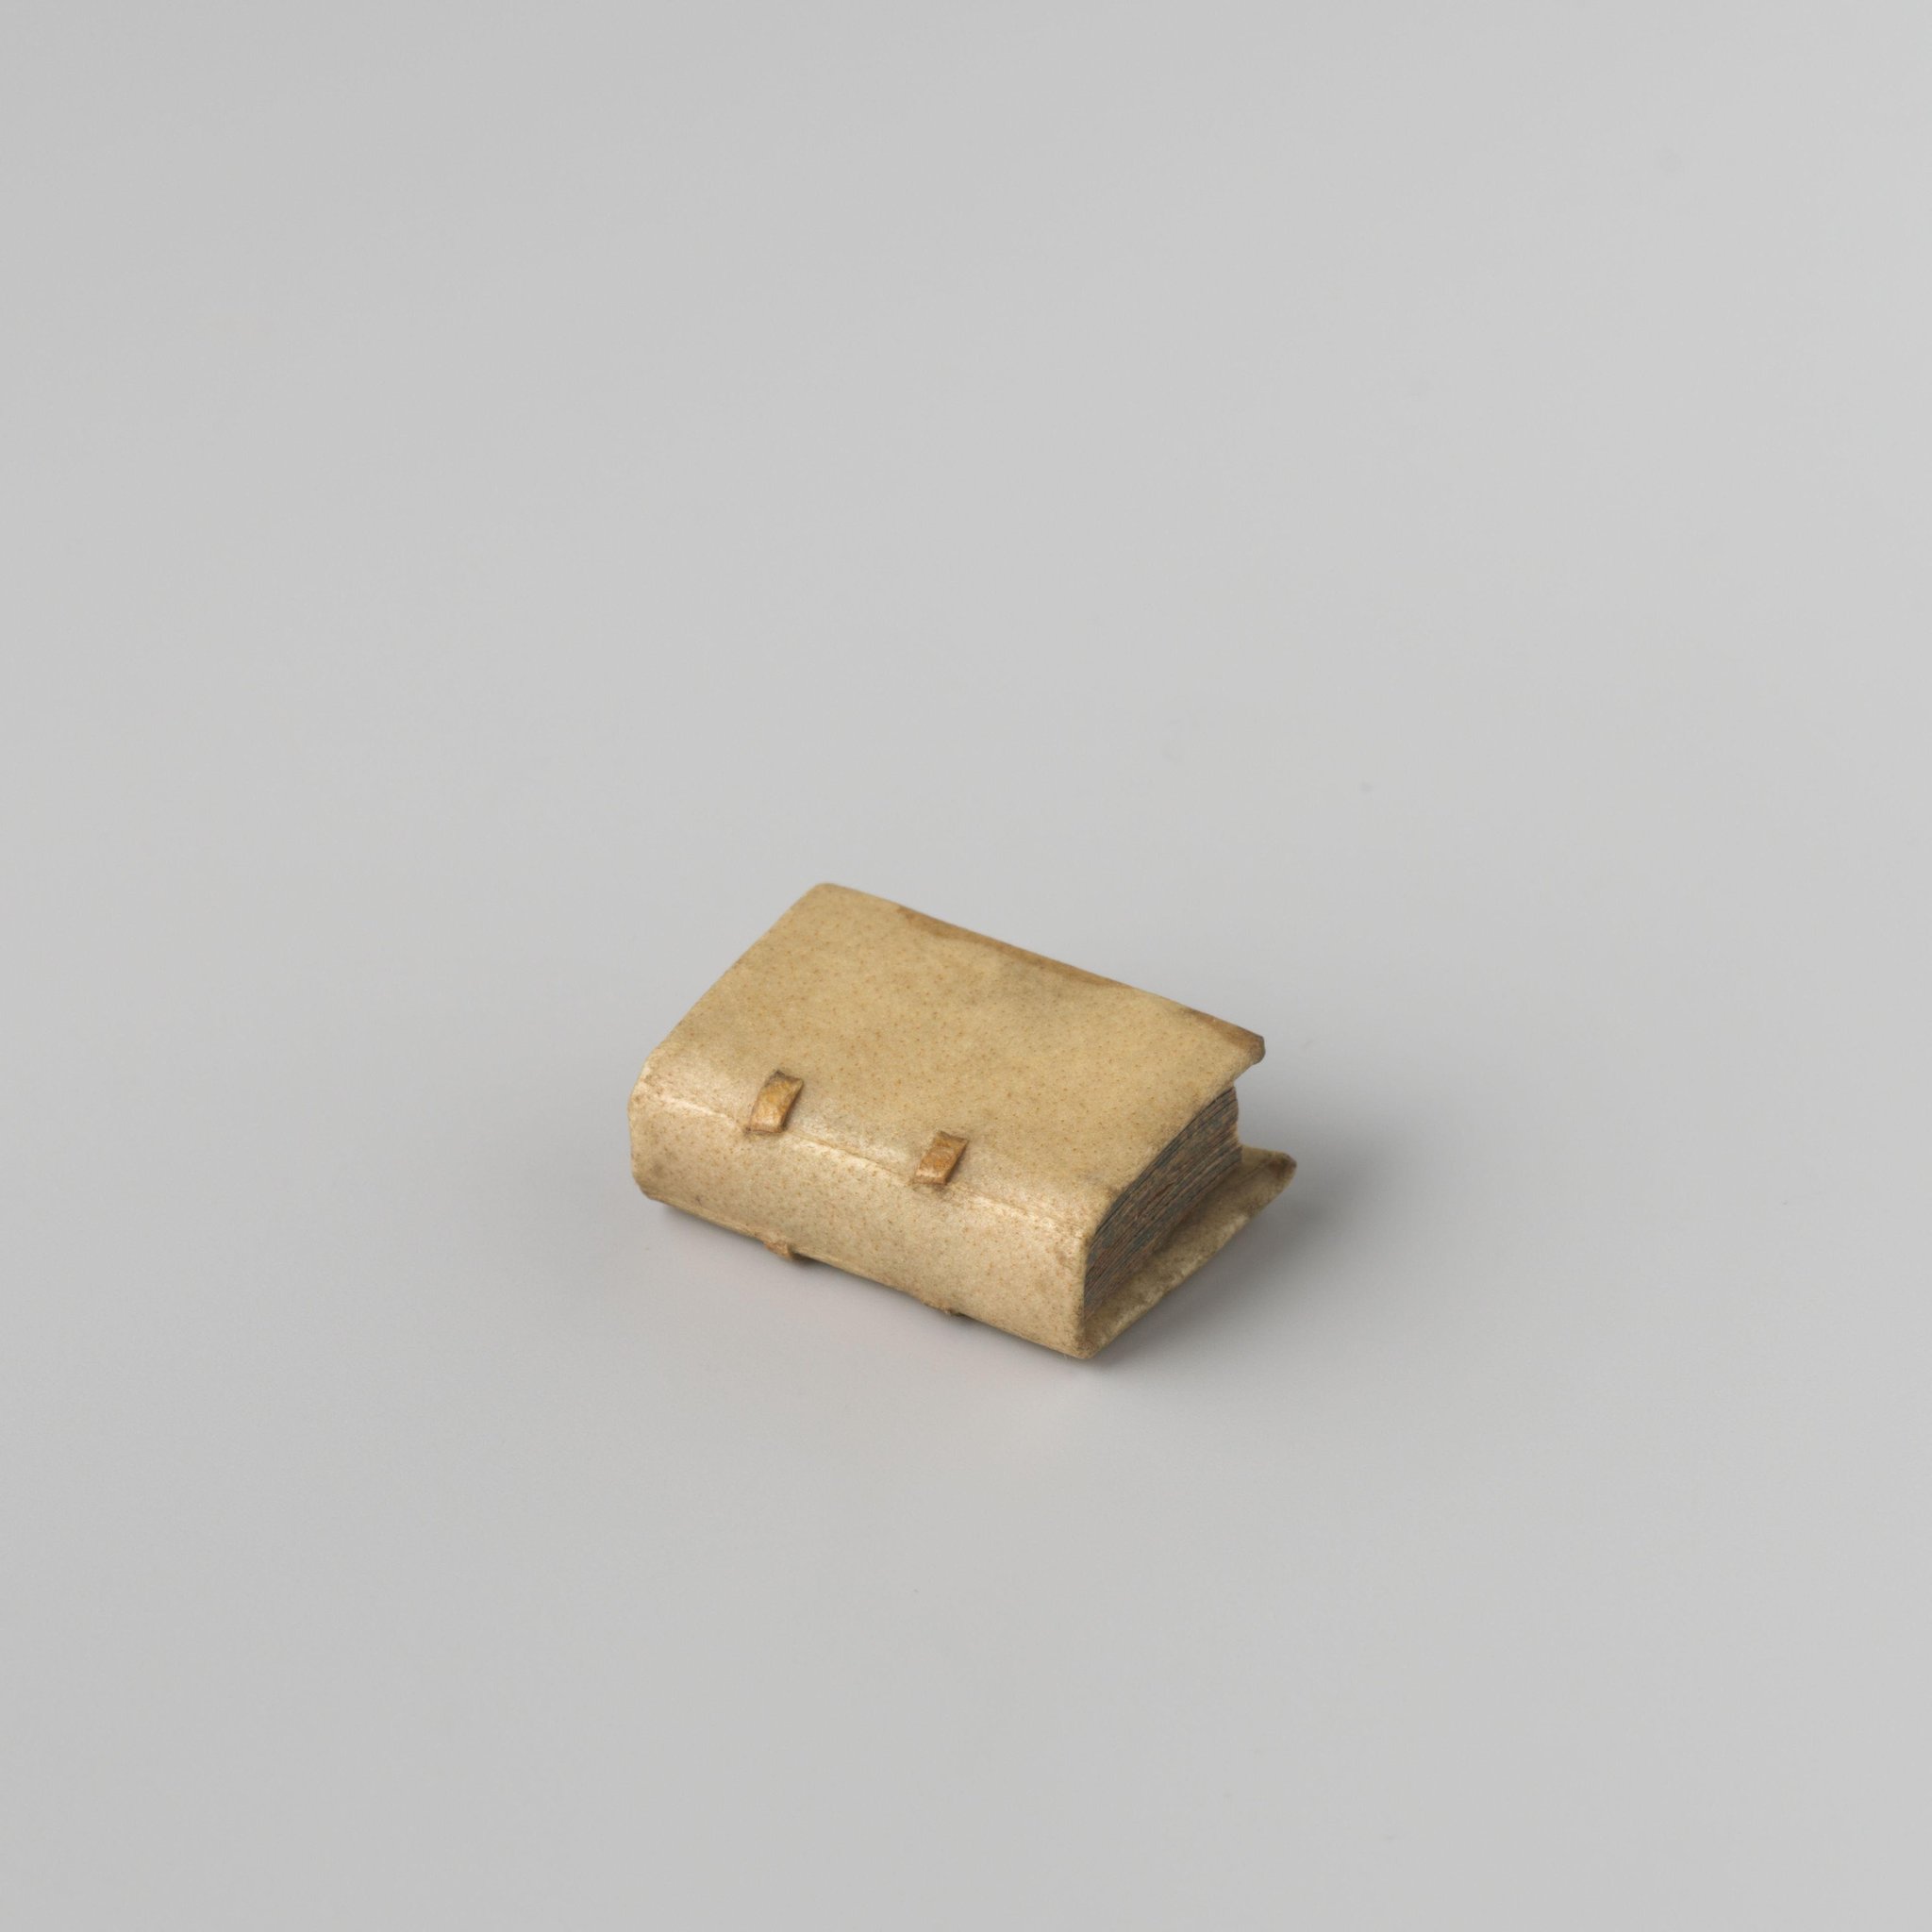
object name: book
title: Boek met figuren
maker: Anonymous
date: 1690-1710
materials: paper, parchment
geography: amsterdam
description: Boek met figuren. Ingebonden in blank perkament.